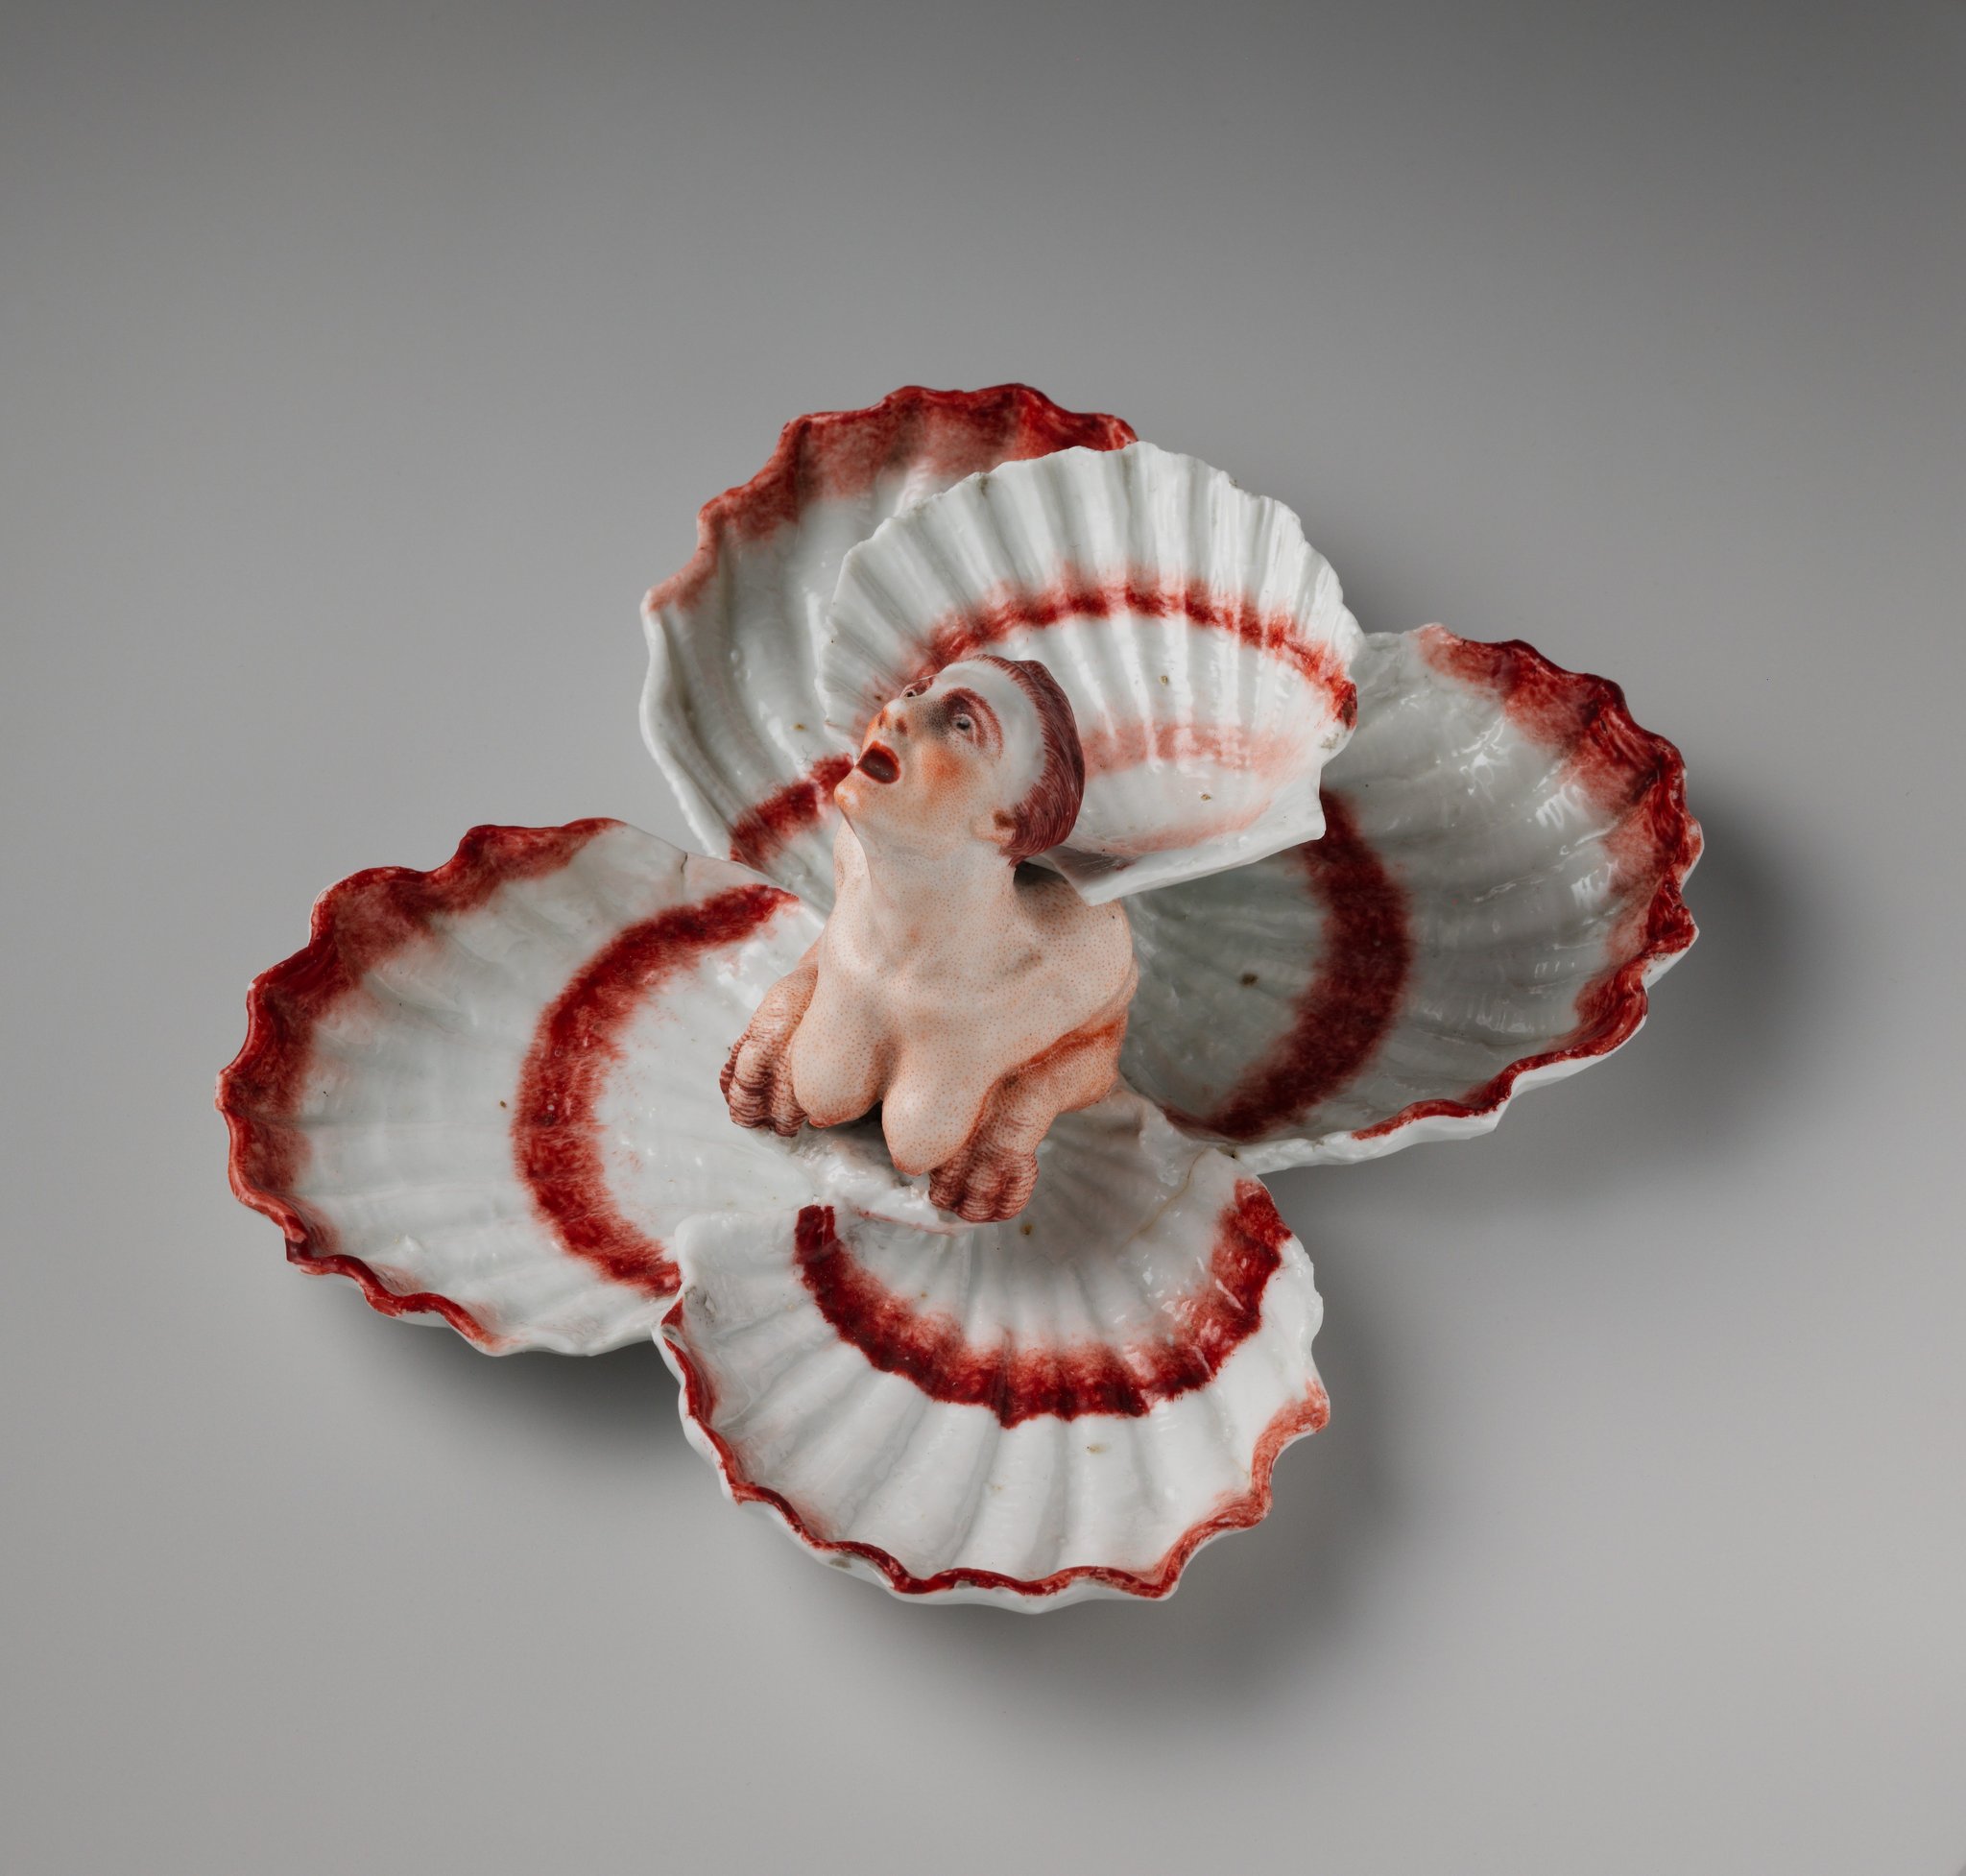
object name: sweetmeat dish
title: Two sweetmeat dishes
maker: doccia porcelain manufactory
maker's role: manufactory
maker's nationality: italian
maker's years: 1737-1896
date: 1750-1760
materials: hard paste porcelain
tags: shells